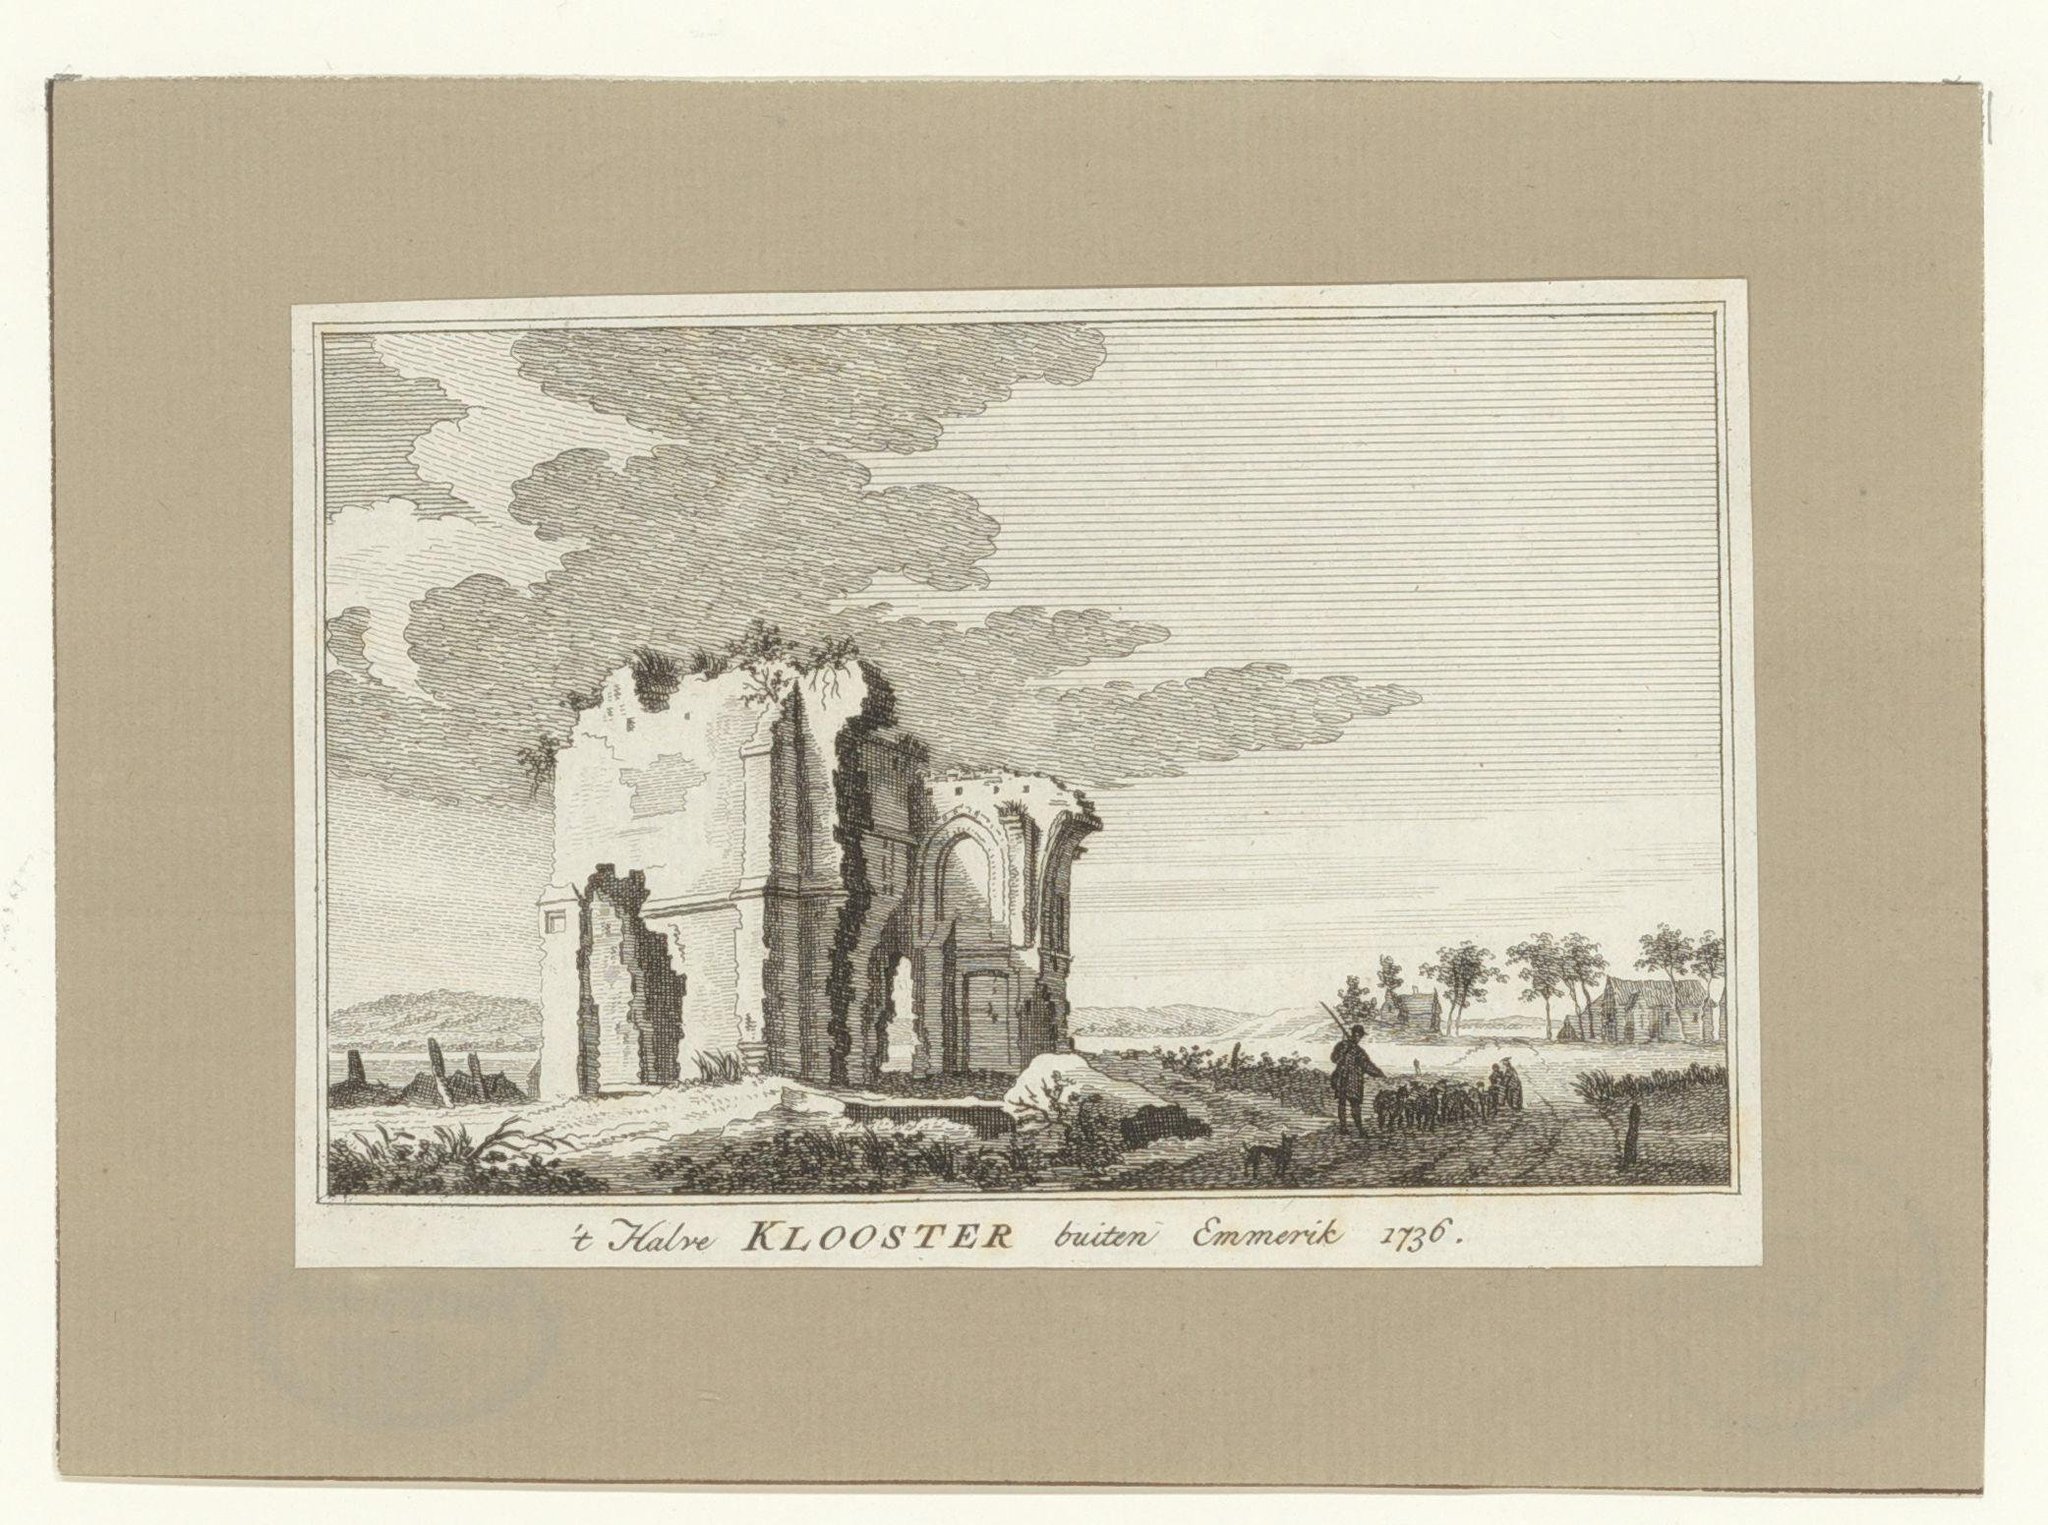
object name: print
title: Ruïne van het klooster buiten Emmerik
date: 1762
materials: paper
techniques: etching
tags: landscape with ruins, ruin of church, monastery, etc.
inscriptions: collector's mark: Lugt 1641, collector's mark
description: Ruïne van het klooster buiten Emmerik, in de toestand omstreeks het jaar 1736. Bovenste helft van een blad met oorspronkelijk twee voorstellingen. Onderwerpsrubrieken binnen de Atlas Zeden en Gewoonten: Kerk en kerkwezen & Armwezen en liefdadige instellingen; Kerkgebouwen elders. V-Z.